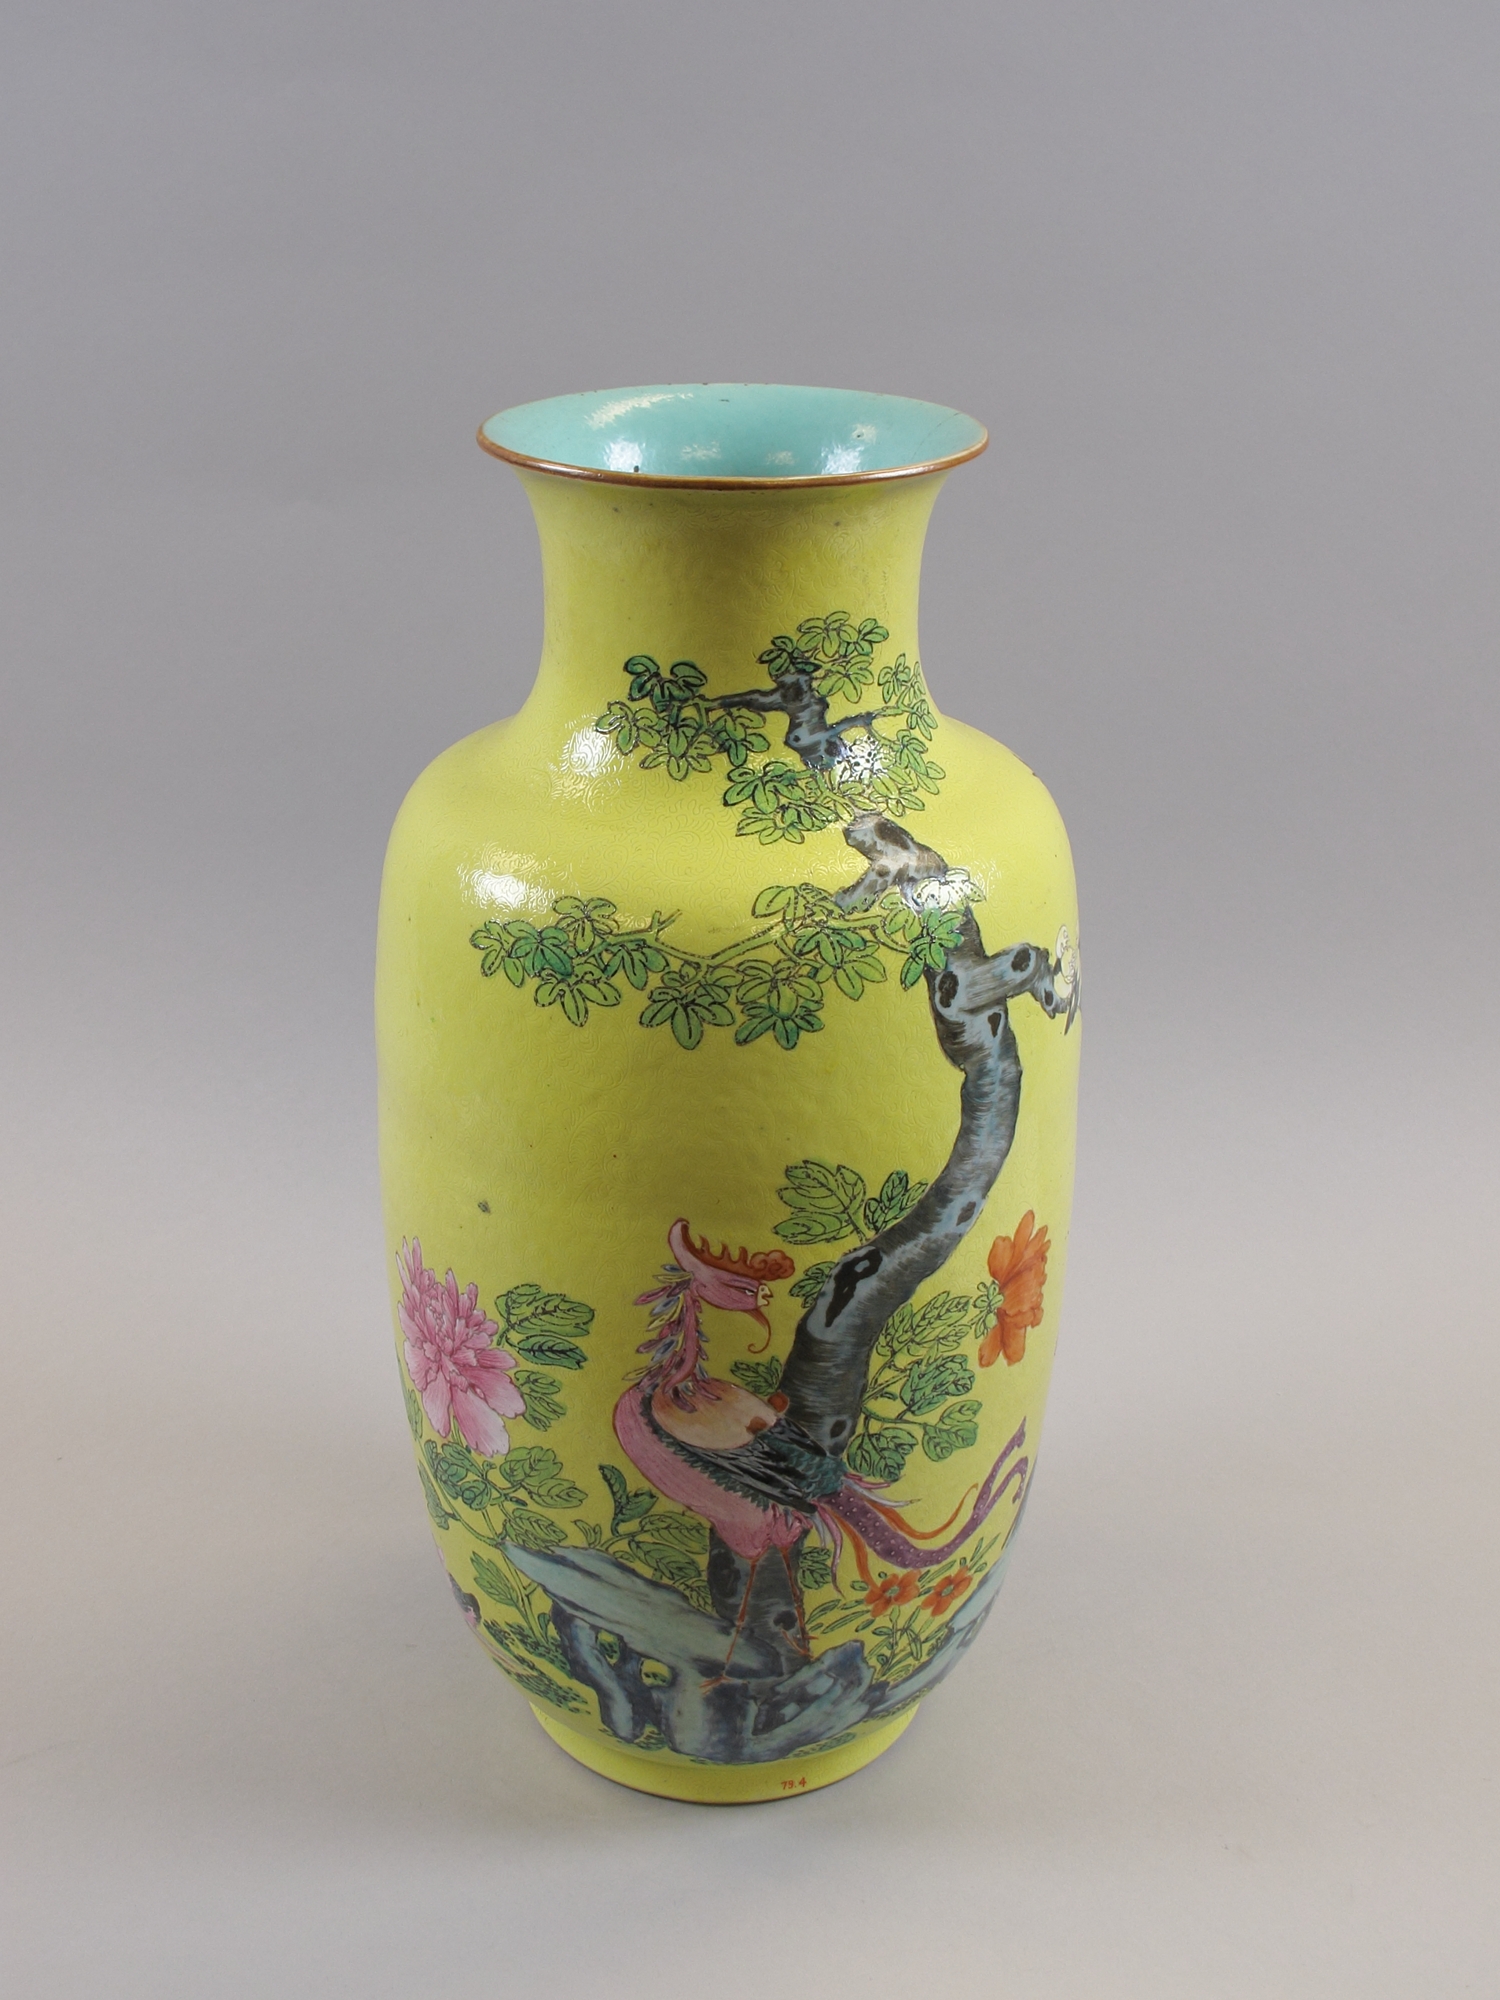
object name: vase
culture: chinese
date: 1801-1850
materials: enamel, glaze, porcelain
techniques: incising, overglaze, painting, polychrome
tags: flowers,trees